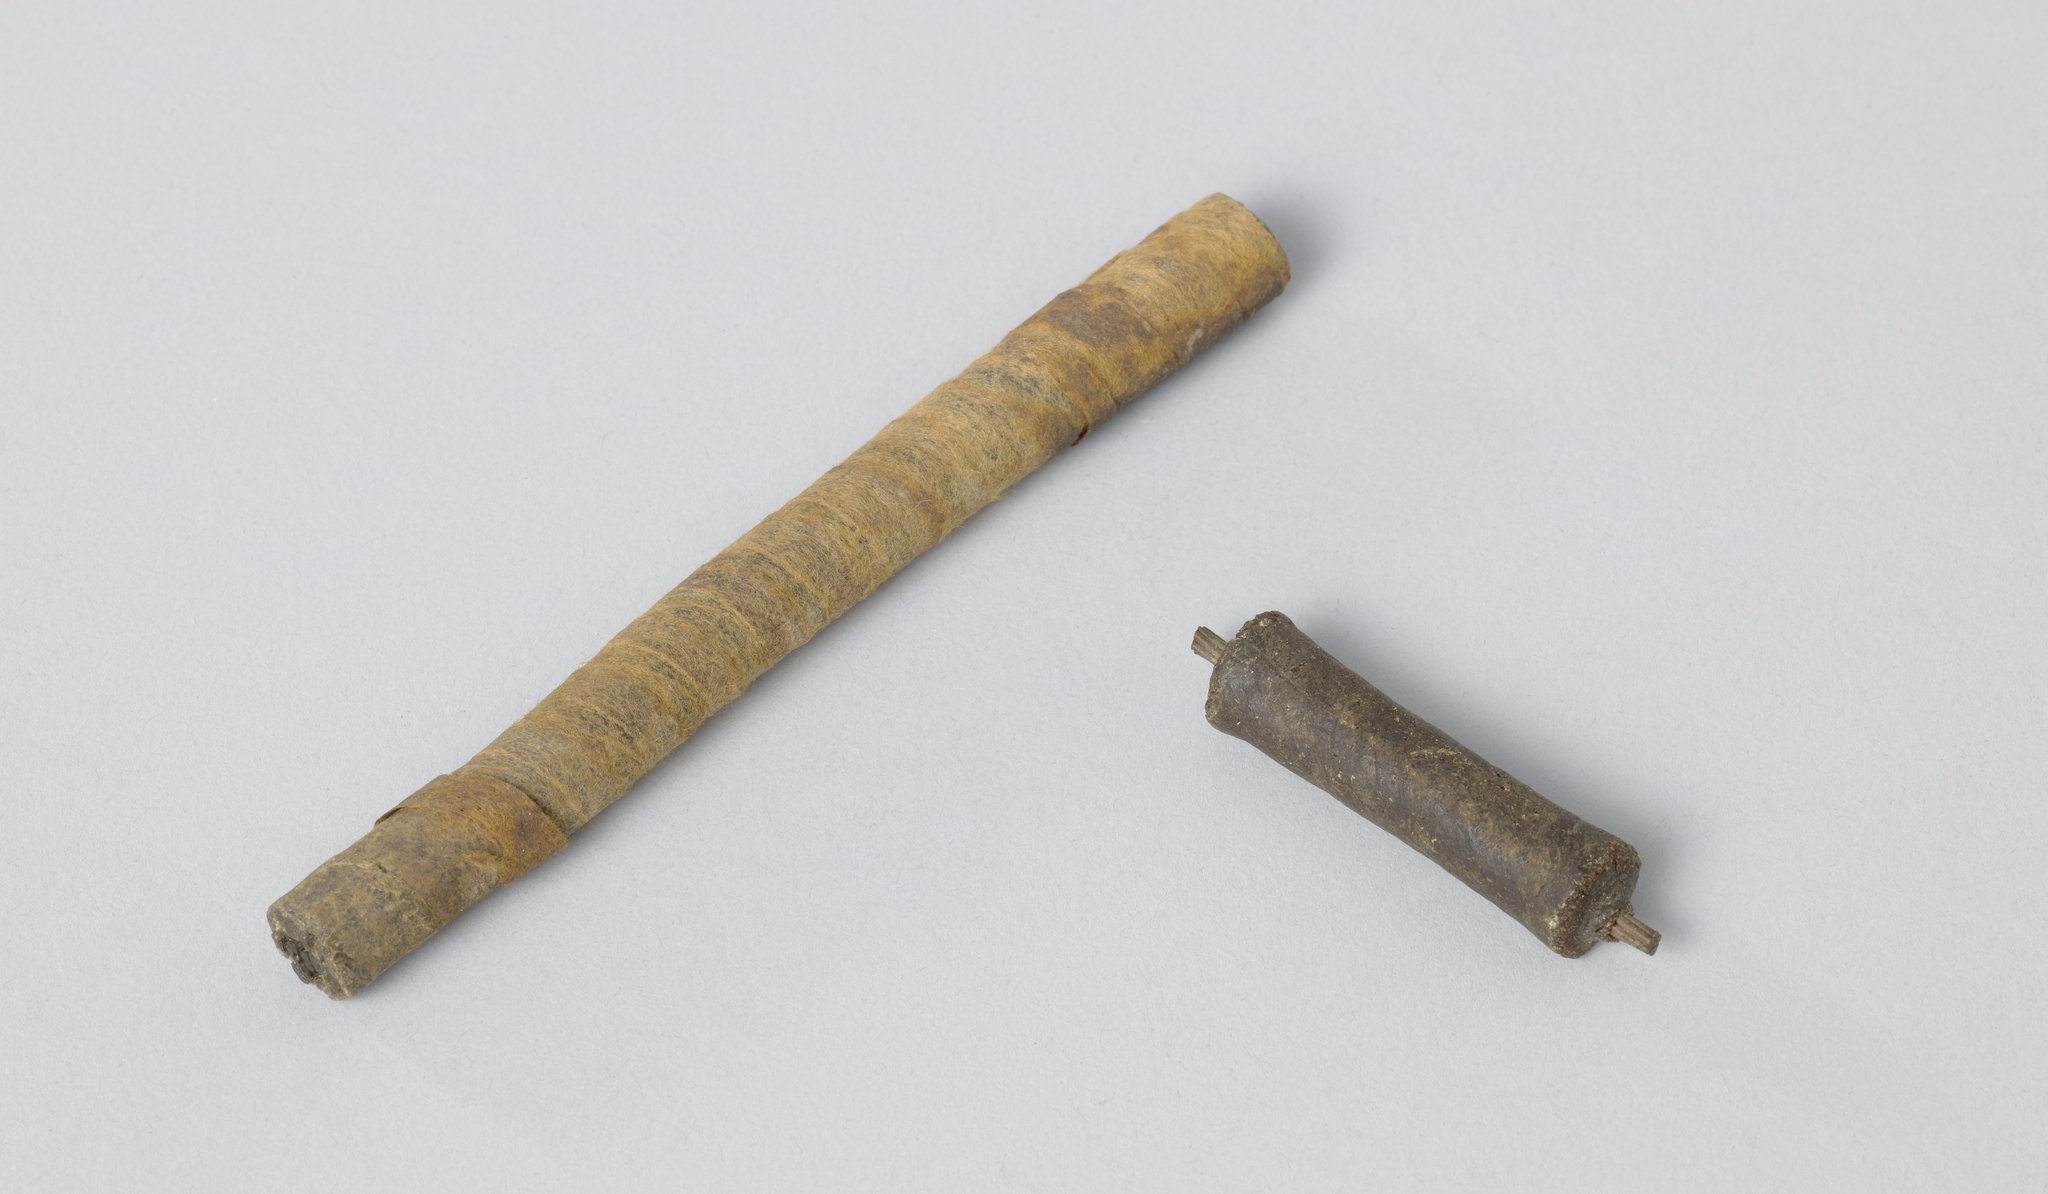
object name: sample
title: Sample of Telegraph Cable for Mines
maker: Anonymous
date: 1865-1875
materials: copper, plastic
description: Oorspronkelijk hoorden er vijf monsters te zijn. Dit soort kabel werd gebruikt om de mijn elektrisch tot ontsteking te brengen.